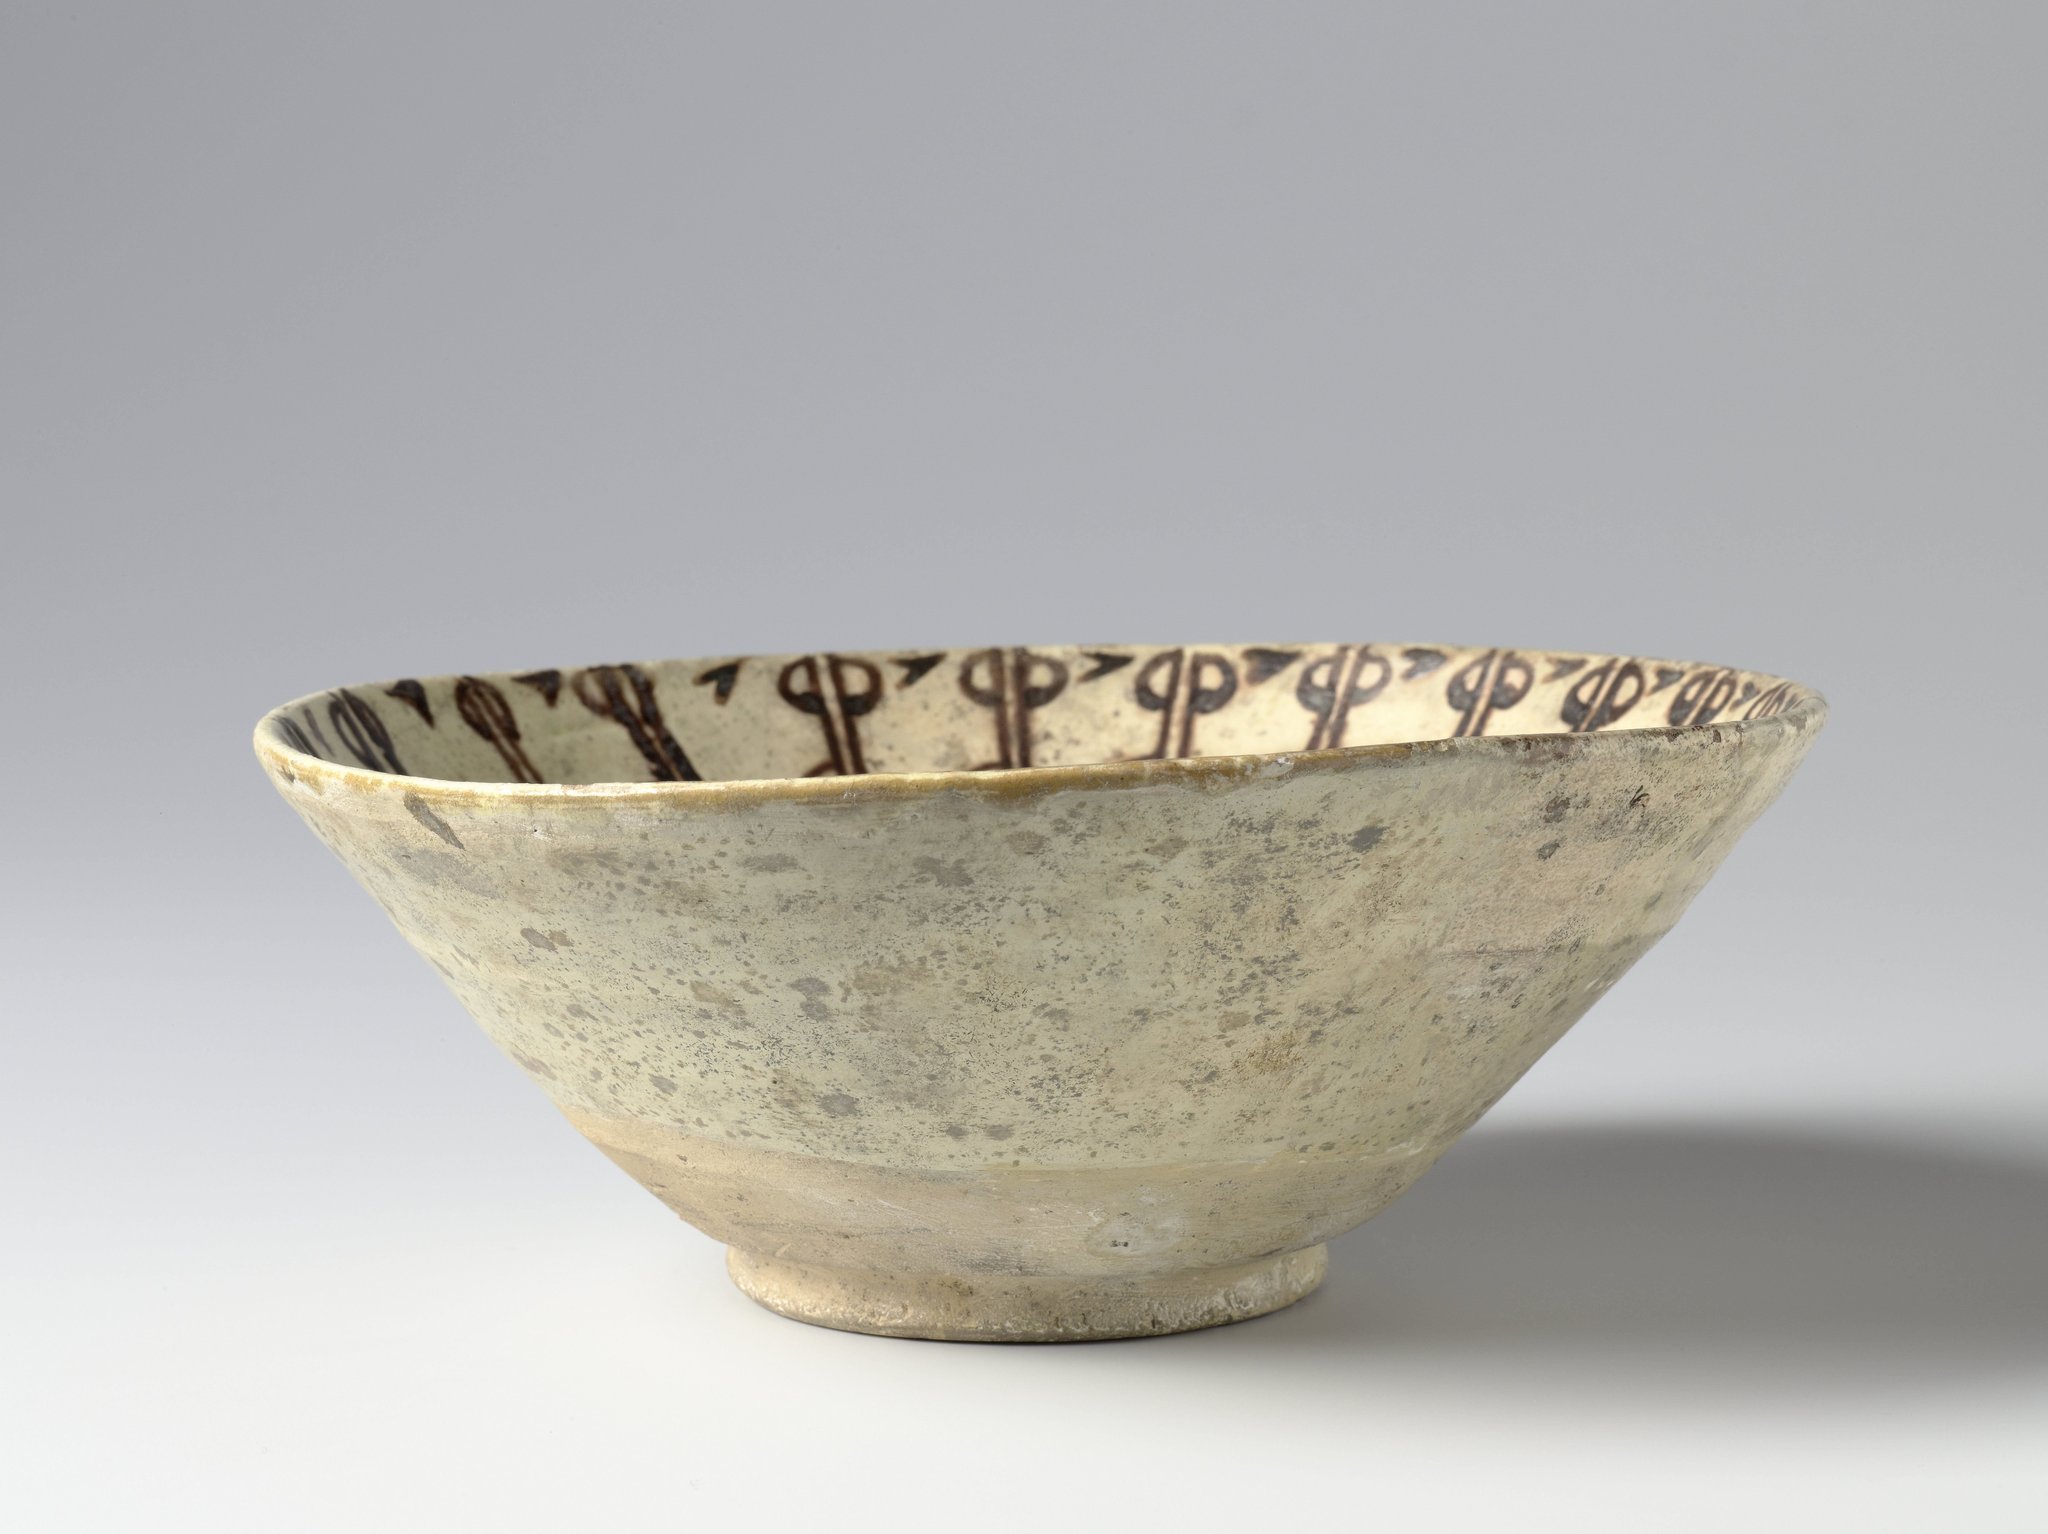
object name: bowl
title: Bowl with a pigeon and a pseudo-inscription border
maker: Anonymous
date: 900-999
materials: earthenware, glaze, paint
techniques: firing, turning, vitrification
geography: sari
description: Kom van aardewerk met witte slib en een beschildering in bruine slib onder een transparant loodglazuur. Op de bodem een duif; de binnenrand met een band met pseudo-schrift.